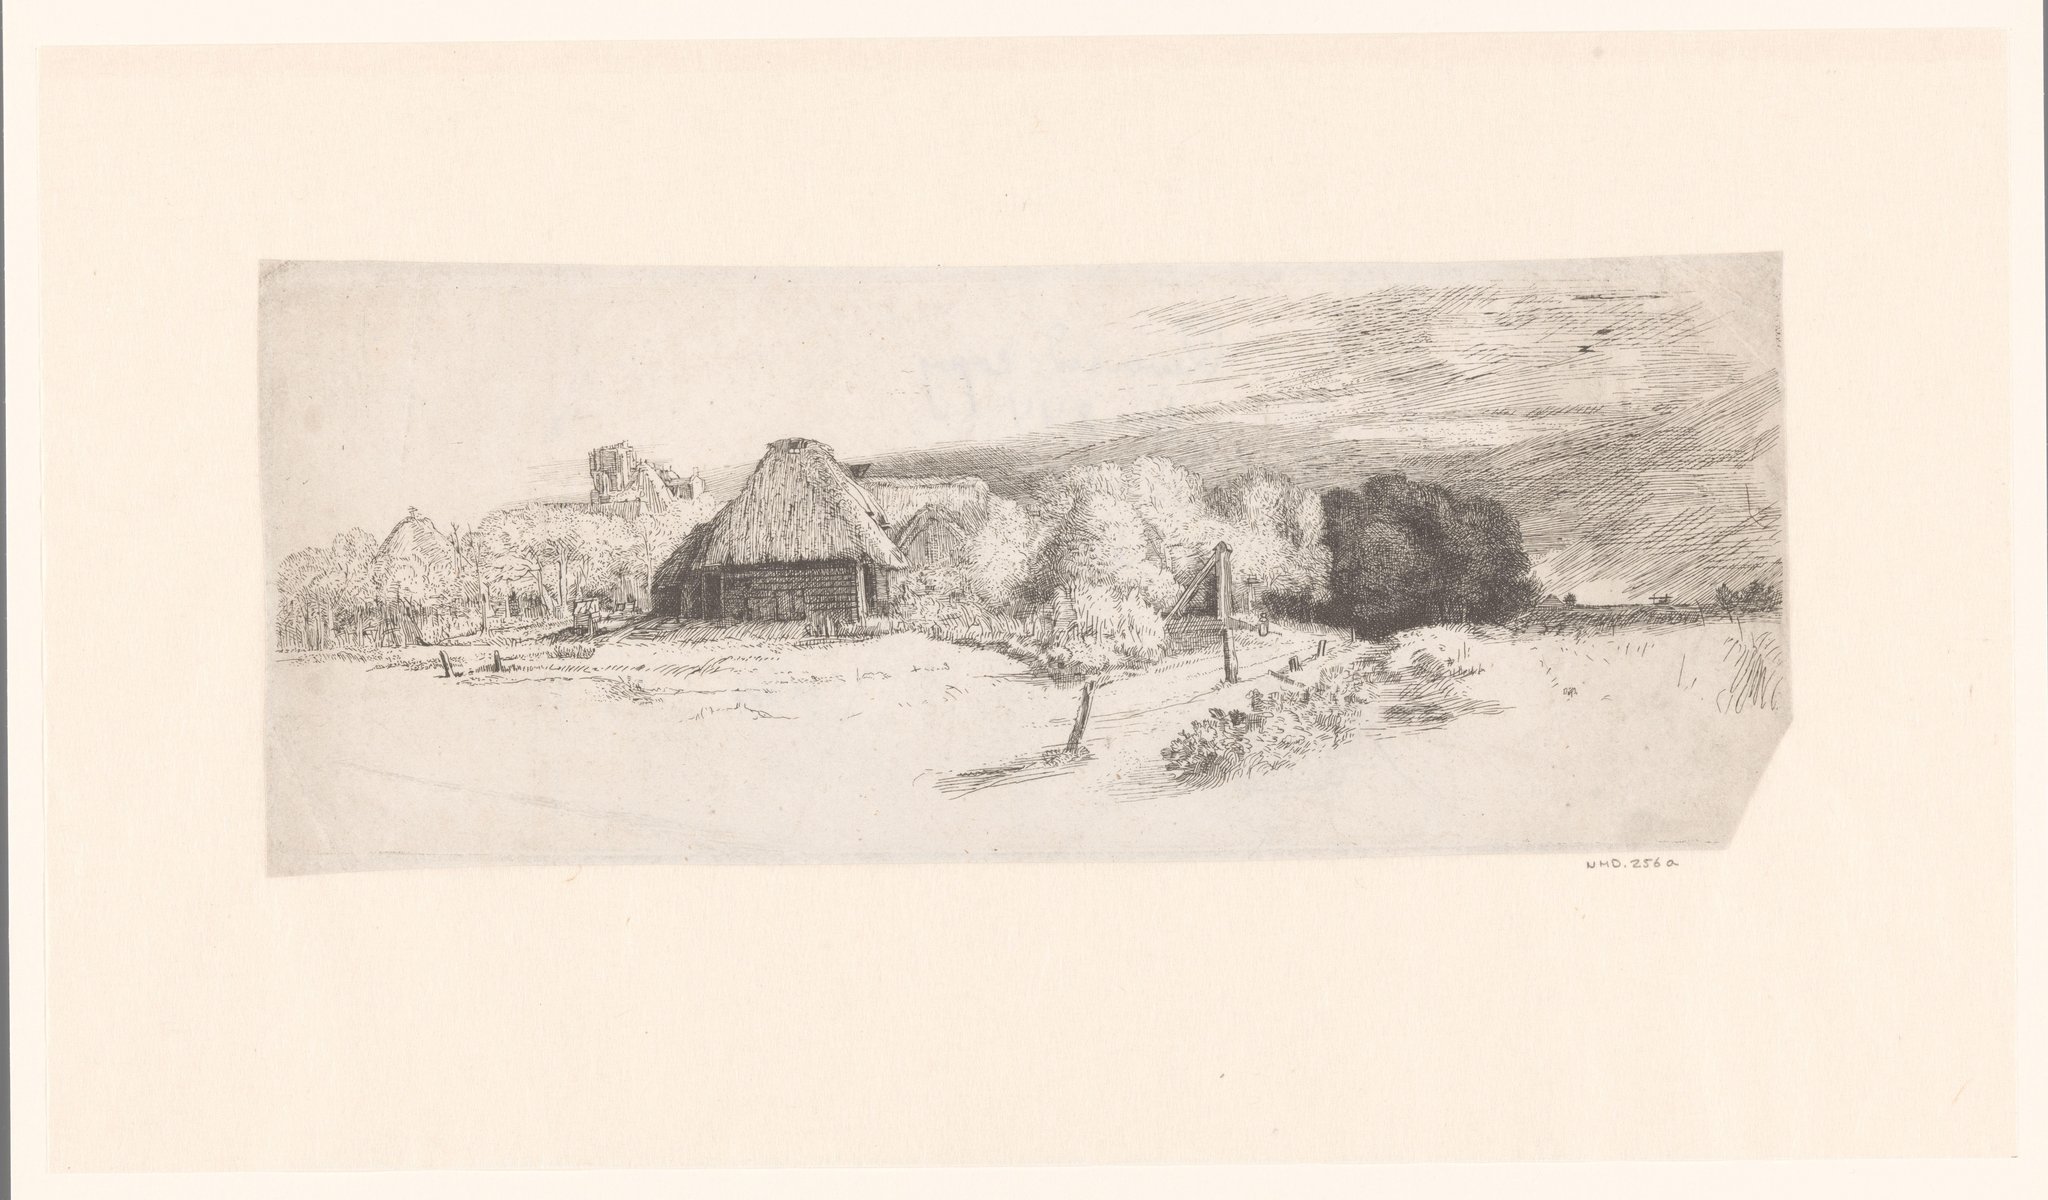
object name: print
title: Landscape with a farm building and the 'house with the tower'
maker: john smith of chichester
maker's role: print maker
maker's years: 1717-1764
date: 1727-1764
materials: paper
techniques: etching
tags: farm or solitary house in landscape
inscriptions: collector's mark: Lugt 2760, collector's mark: Lugt 2228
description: Spiegelbeeldige kopie naar de gelijknamige prent van Rembrandt.